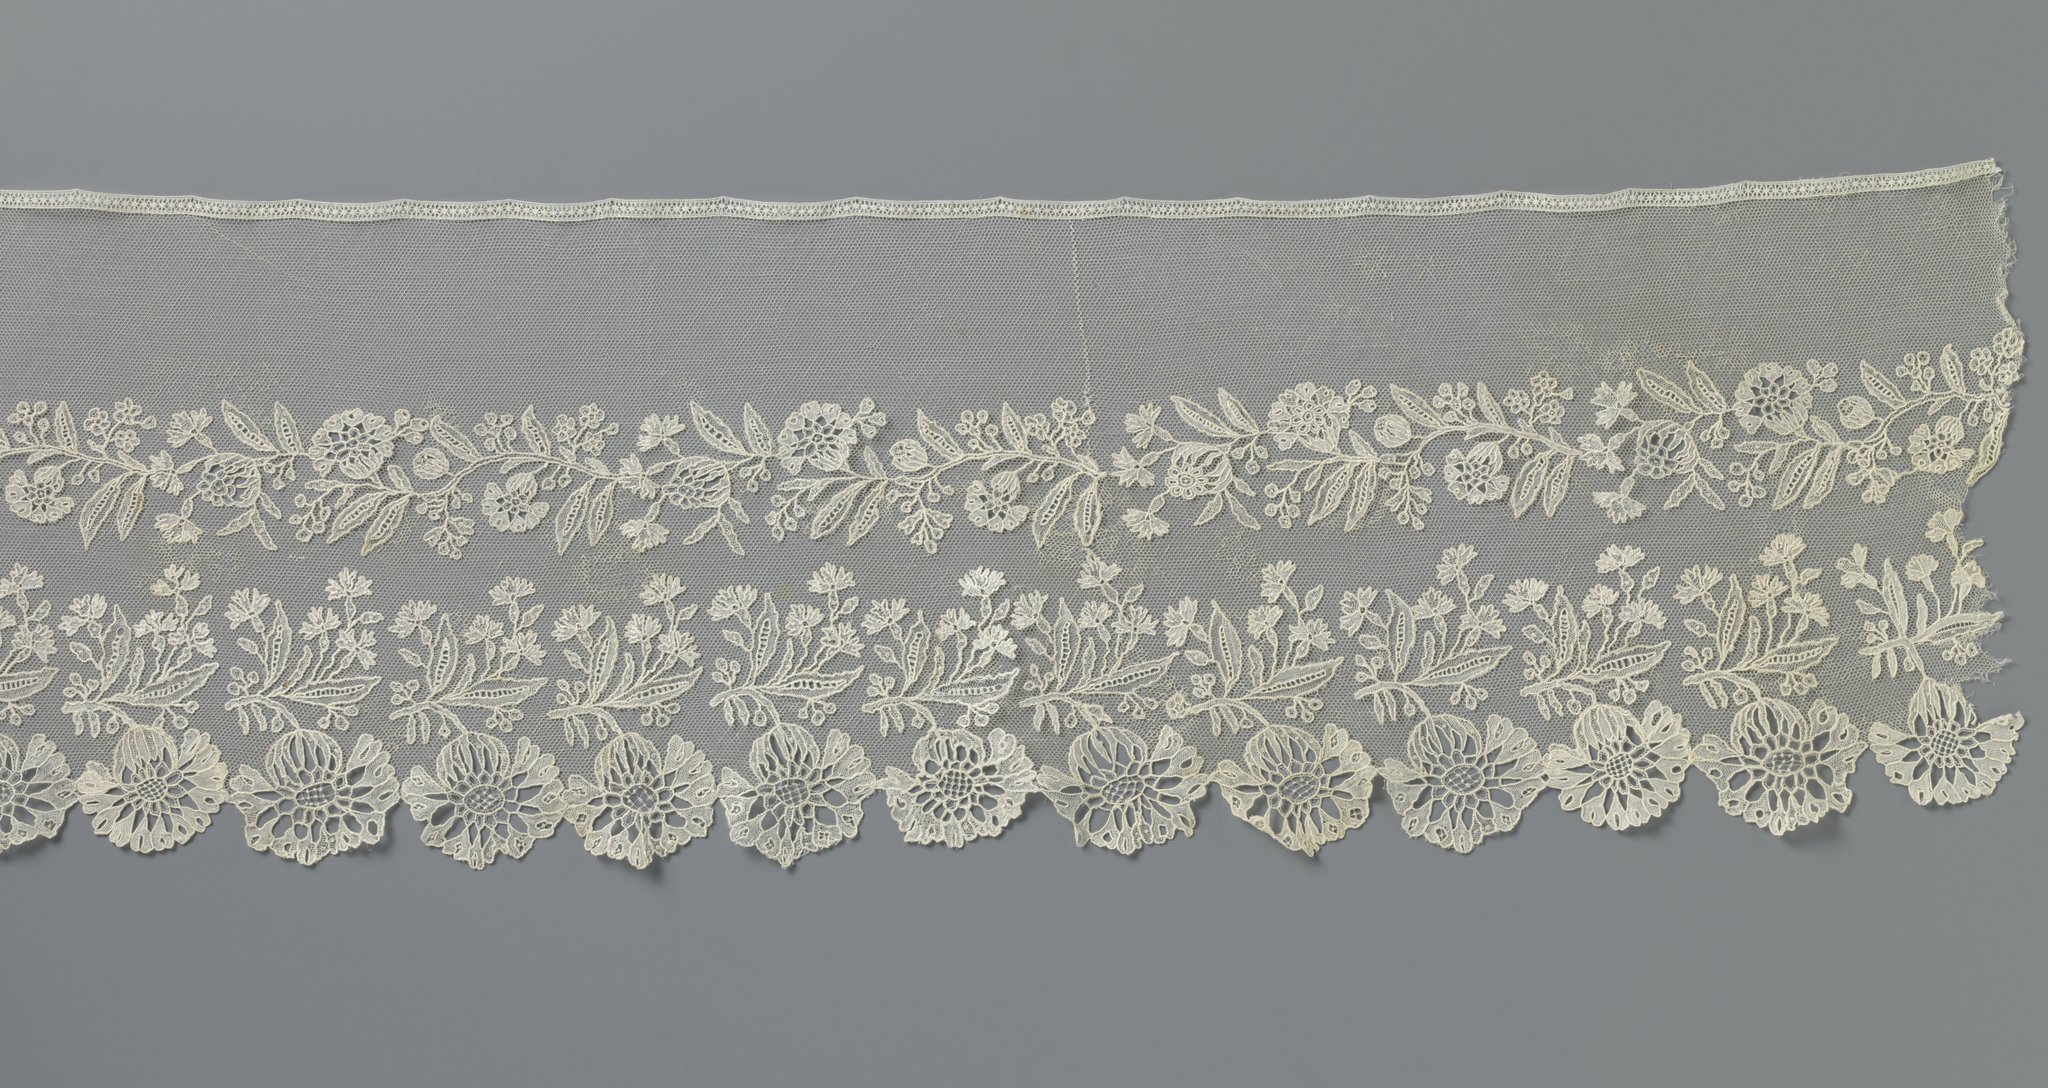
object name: strip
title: Japonstrook van applicatiekant met hangende bloemen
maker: Anonymous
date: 1820-1840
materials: linen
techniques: lace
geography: brussels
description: Japonstrook naturelkleurige applicatiekant, naaldkant geappliceerd op machinale tule, point d'Angleterre. Een rand van ronde schulpen wordt gevormd door een aaneegesloten rij van grote bloemen die, naar rechts, van kleine bloemtakjes afhangen. Los daarboven loopt een smalle rand van een golvende tak met kleinere soortgelijke bloemen. Het bovendeel bestaat uit een fond van onversierde tule. Twee smallere stroken hebben eenzelfde, en een verkleind patroon.